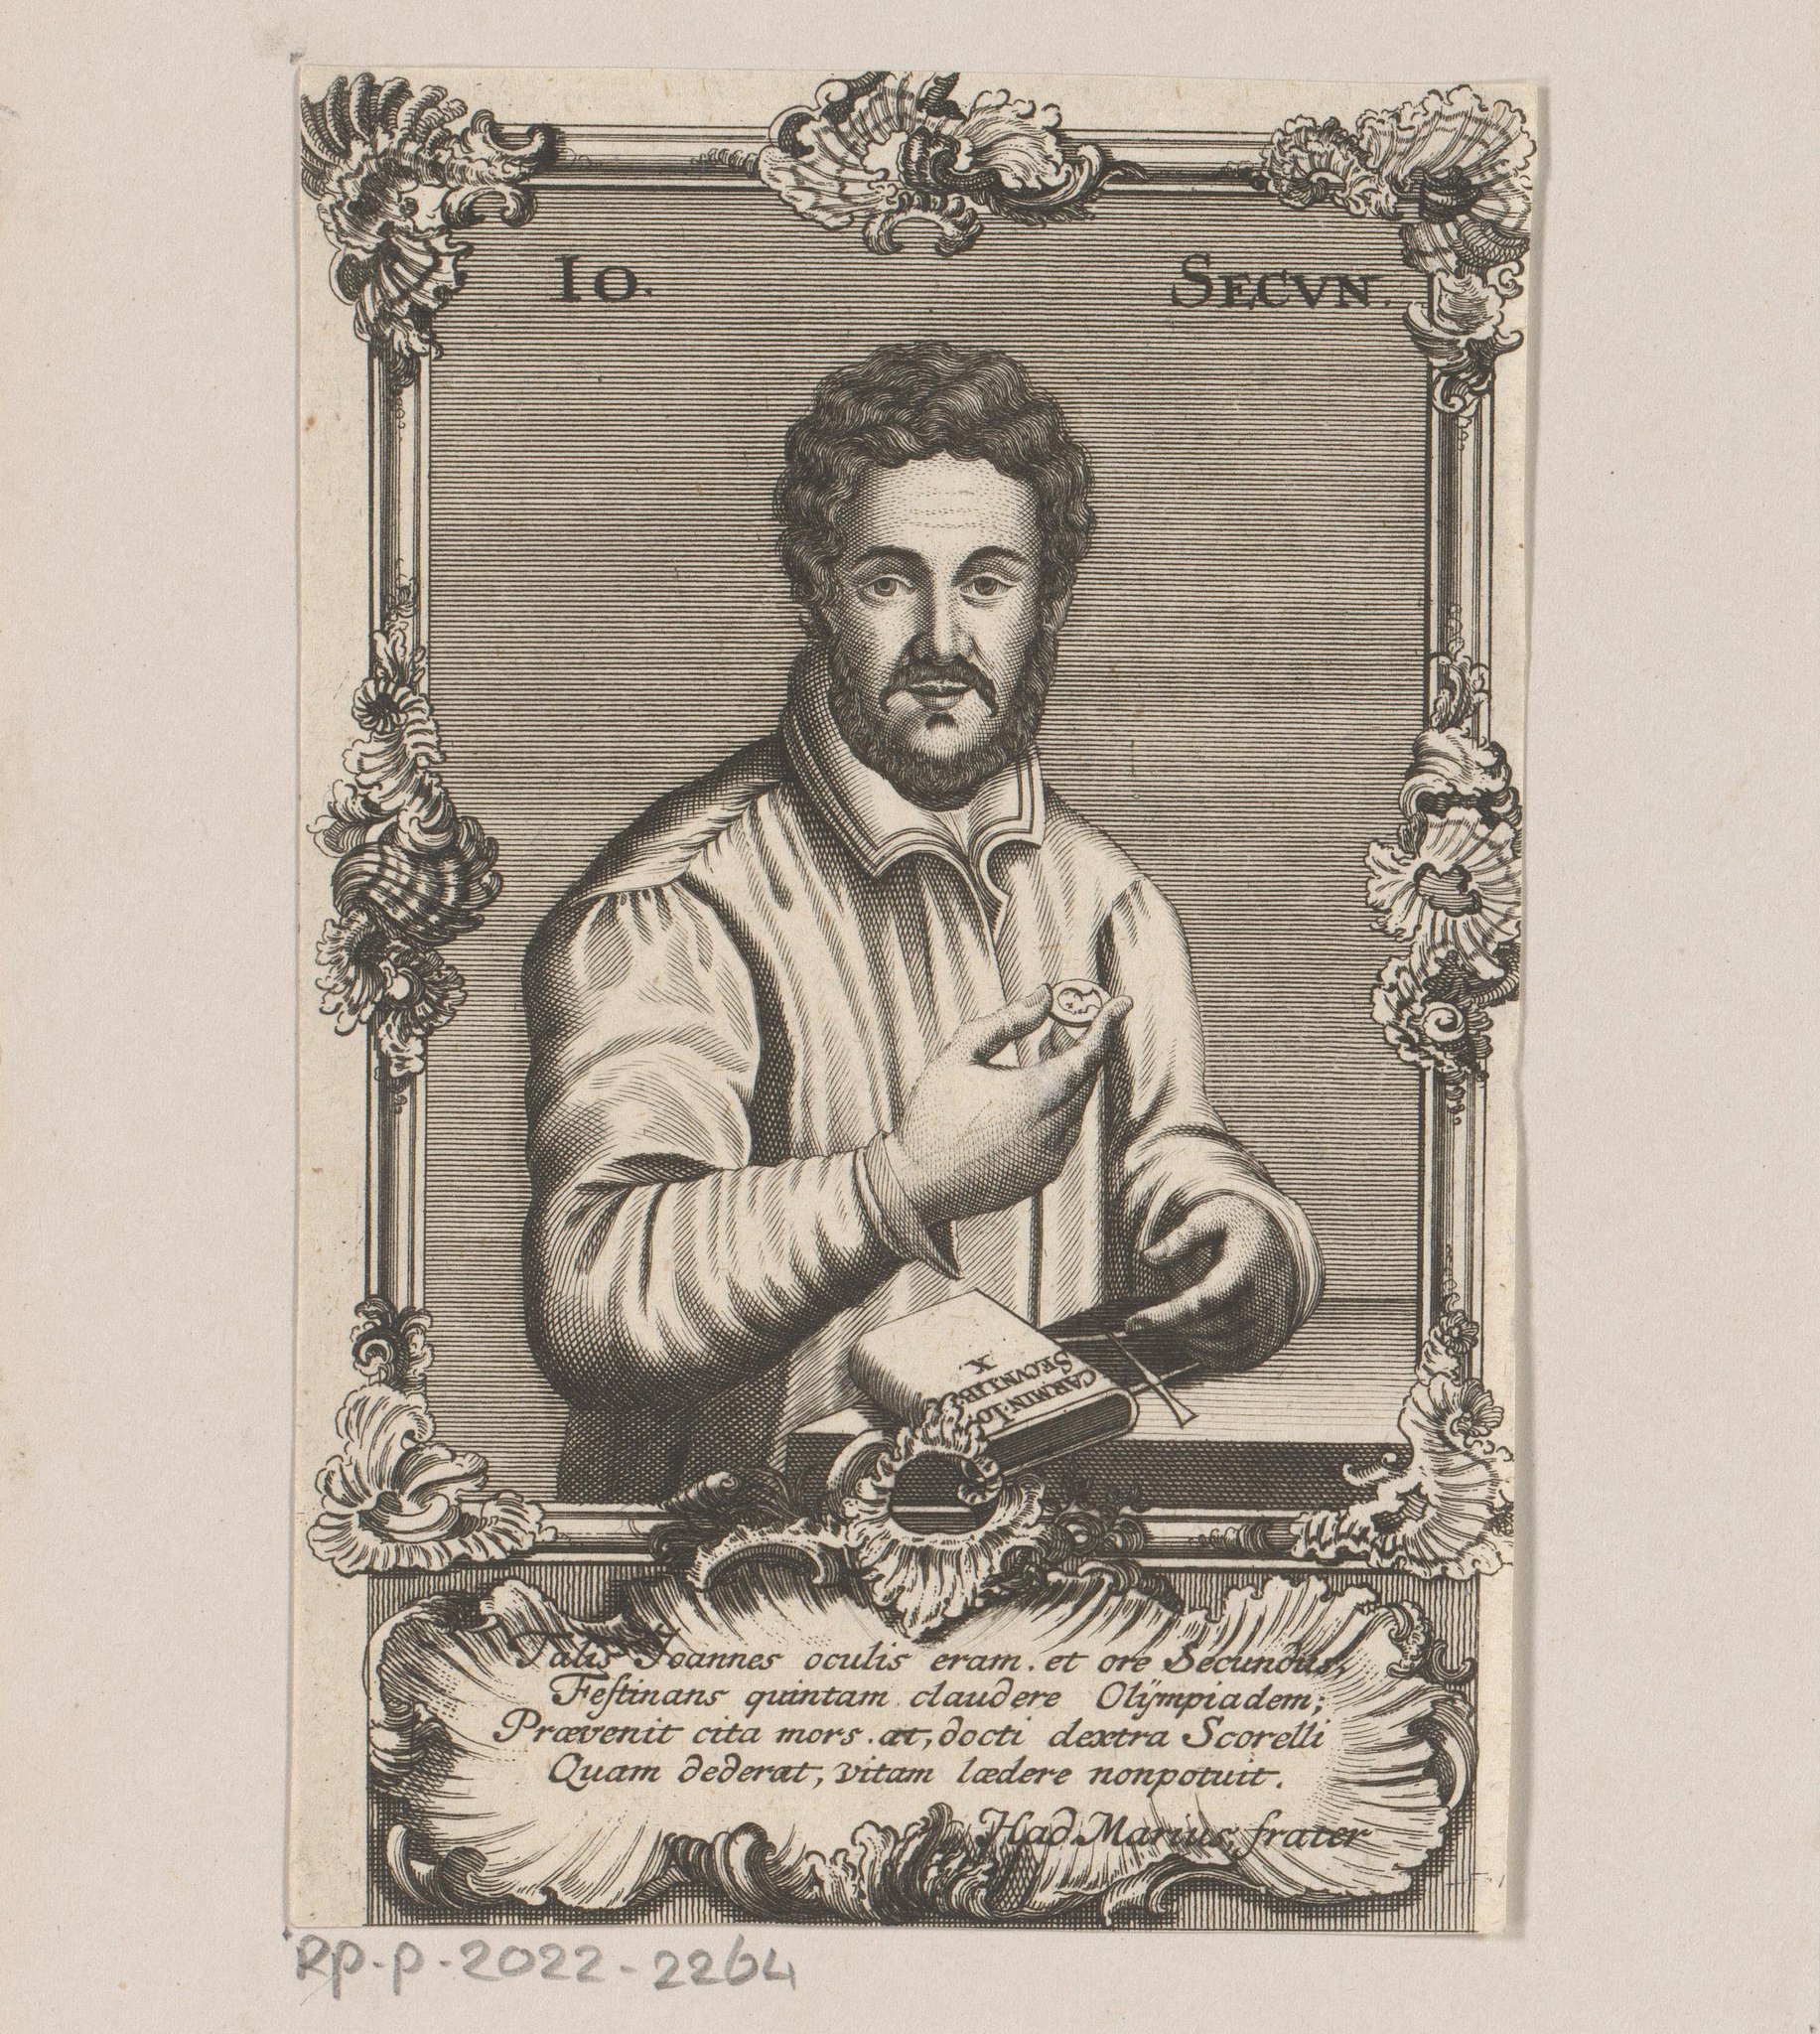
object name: print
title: Portret van Janus Secundus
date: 1600-1750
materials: paper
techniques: engraving, etching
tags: the hague, janus secundus, historical persons, portrait of a writer, writer, poet, author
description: Met vierregelig onderschrift in het Latijn.